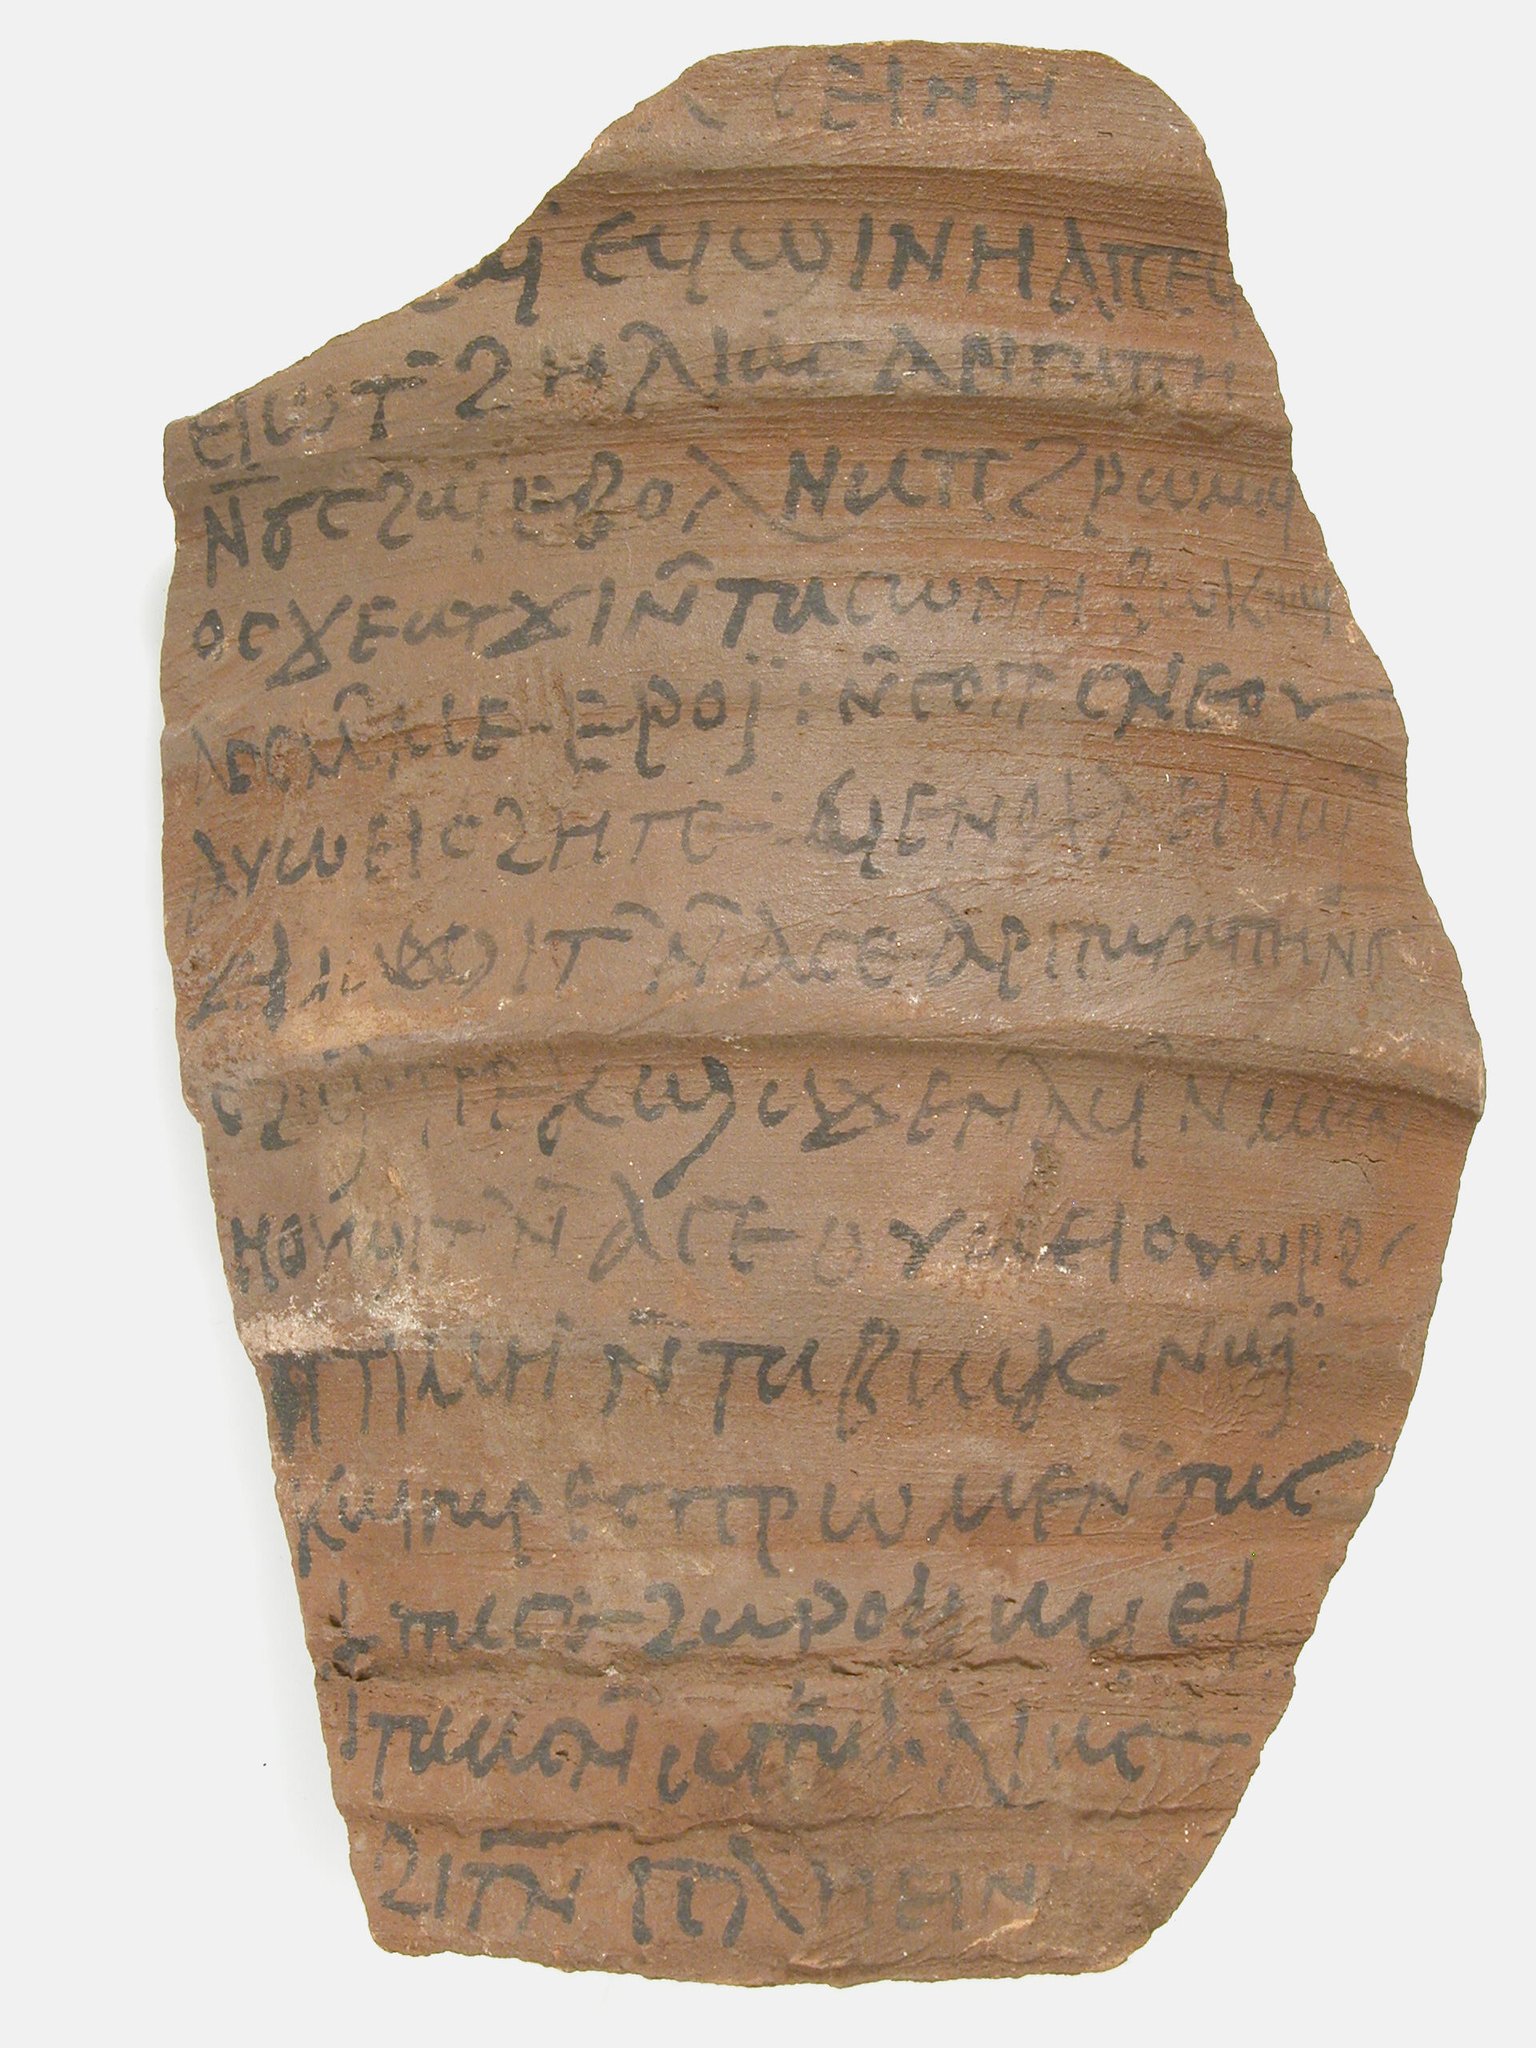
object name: ostrakon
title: Ostrakon with a Letter from Pleine to Elias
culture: coptic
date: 600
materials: ink, pottery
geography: egypt